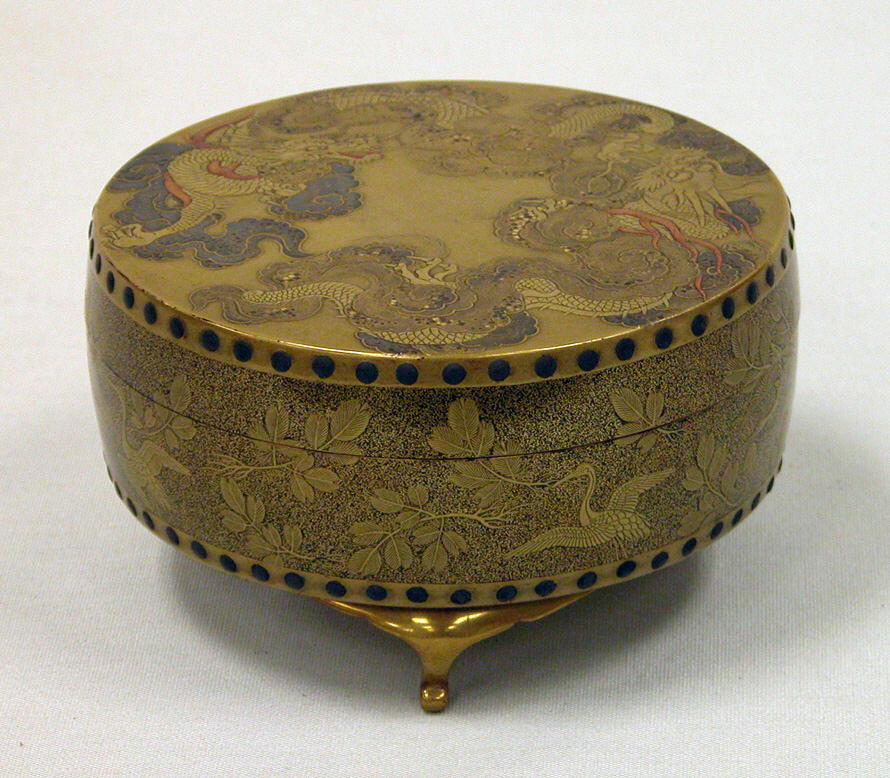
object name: incense box with tray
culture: japanese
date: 1701-1800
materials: gold, lacquer, silver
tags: birds,dragons,leaves